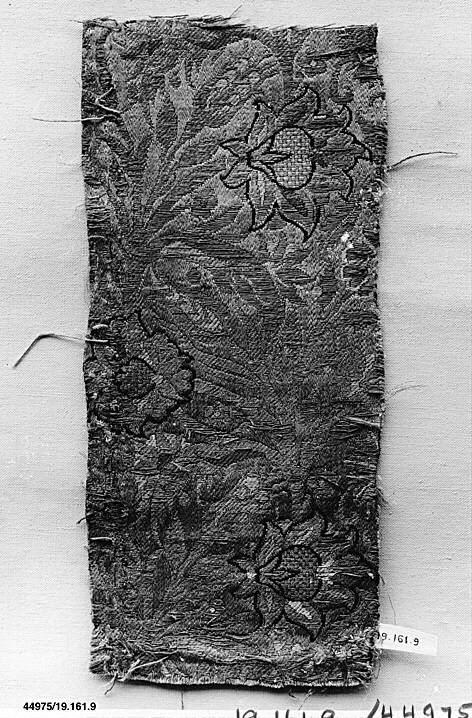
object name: textile fragment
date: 1501-1700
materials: silk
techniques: brocade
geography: turkey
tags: flowers